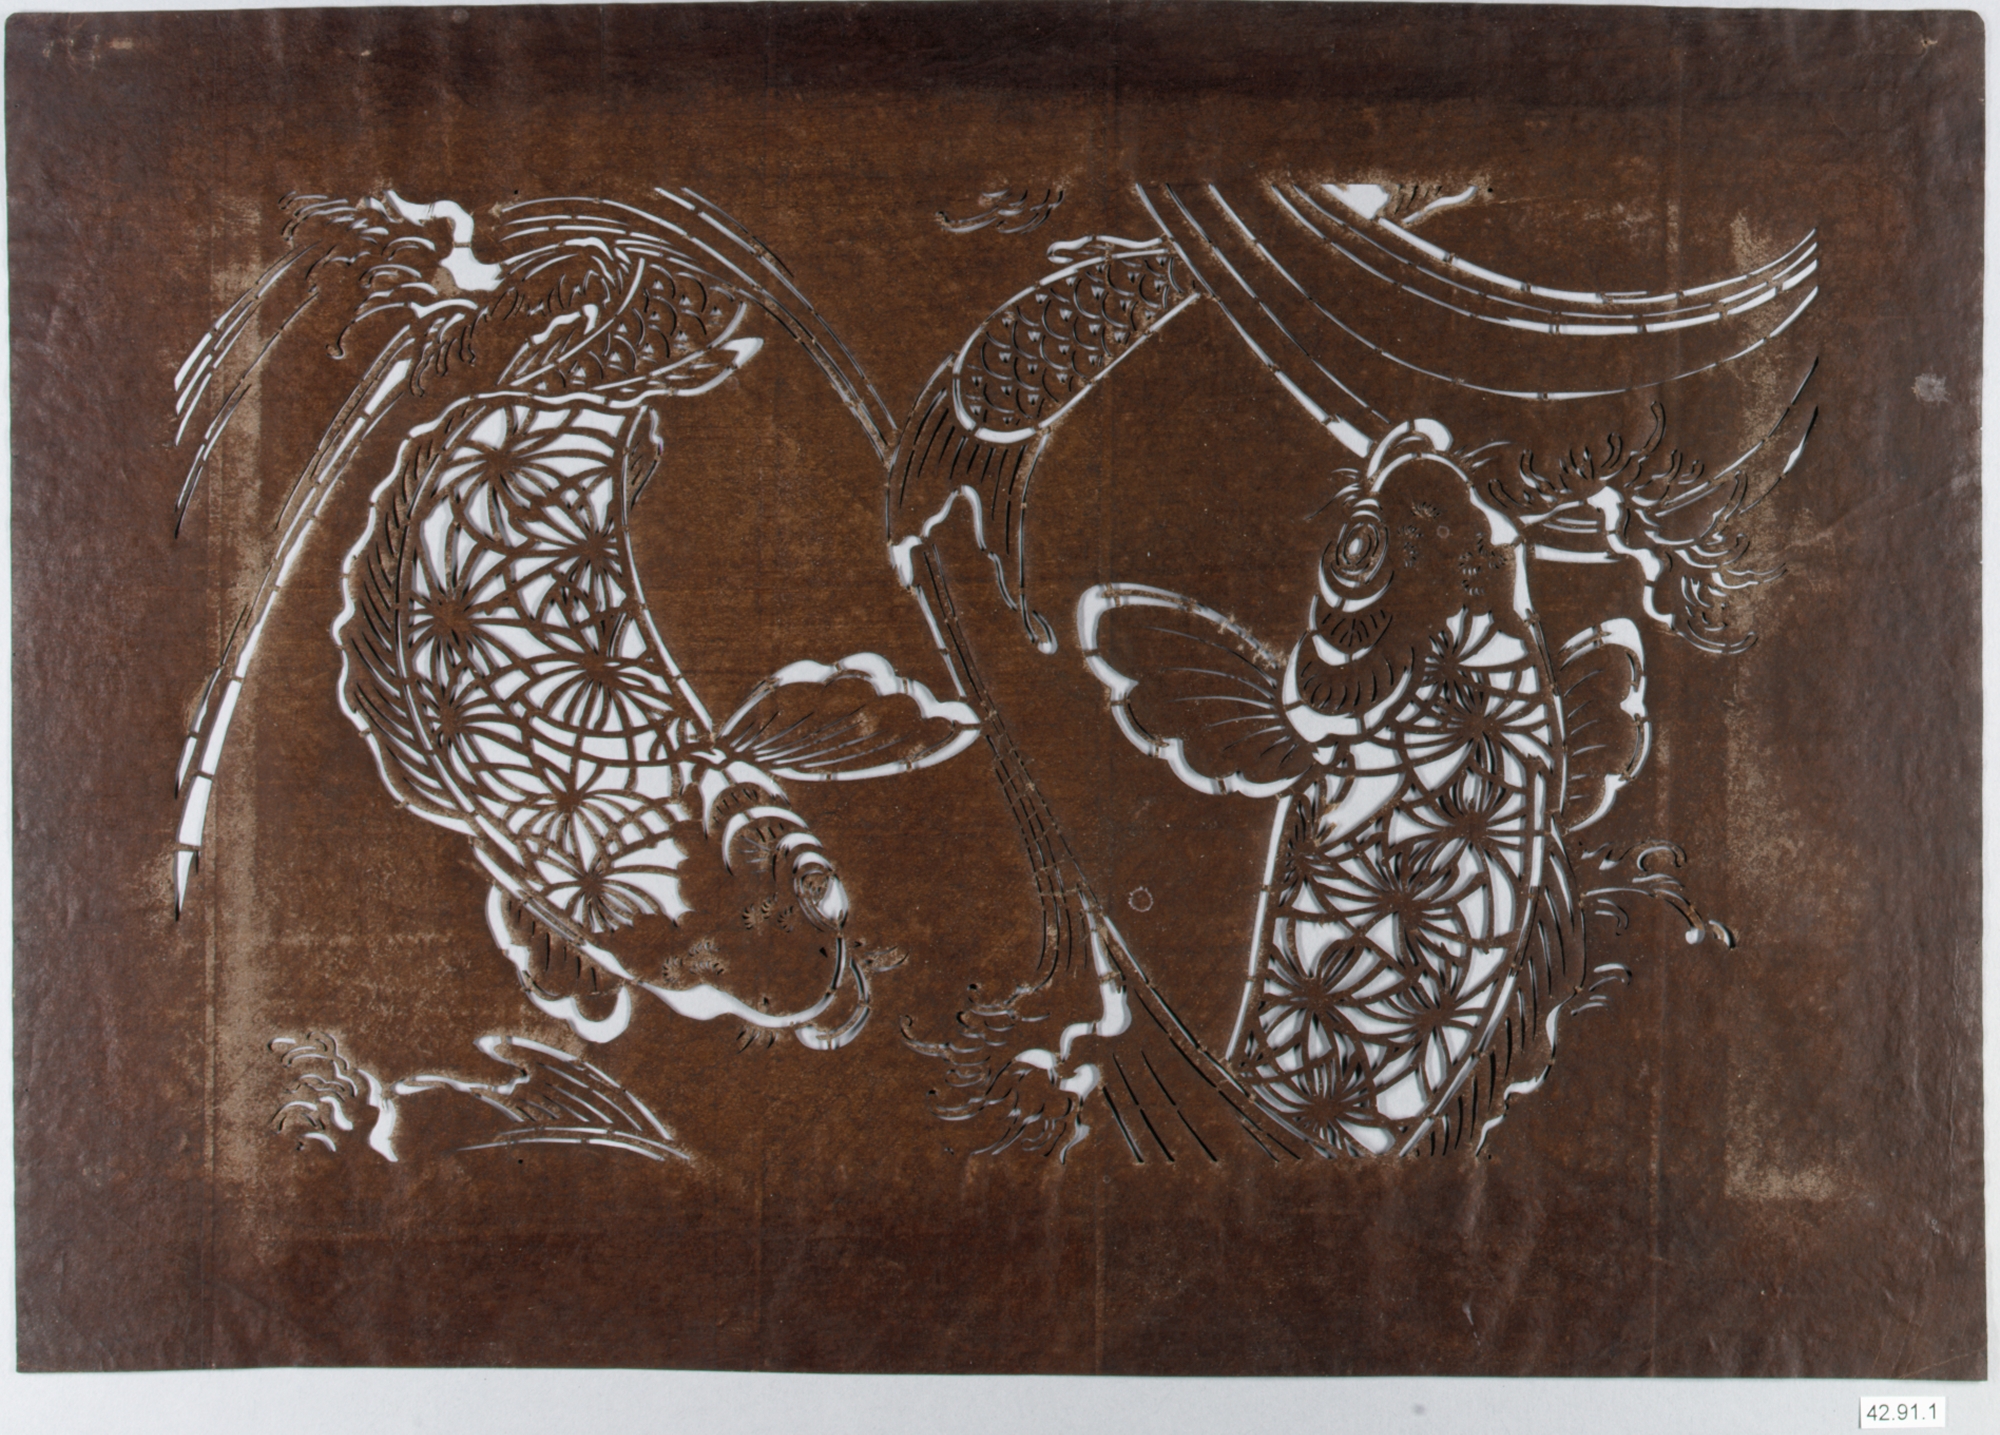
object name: stencil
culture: japanese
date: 1801-1900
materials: paper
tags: fish